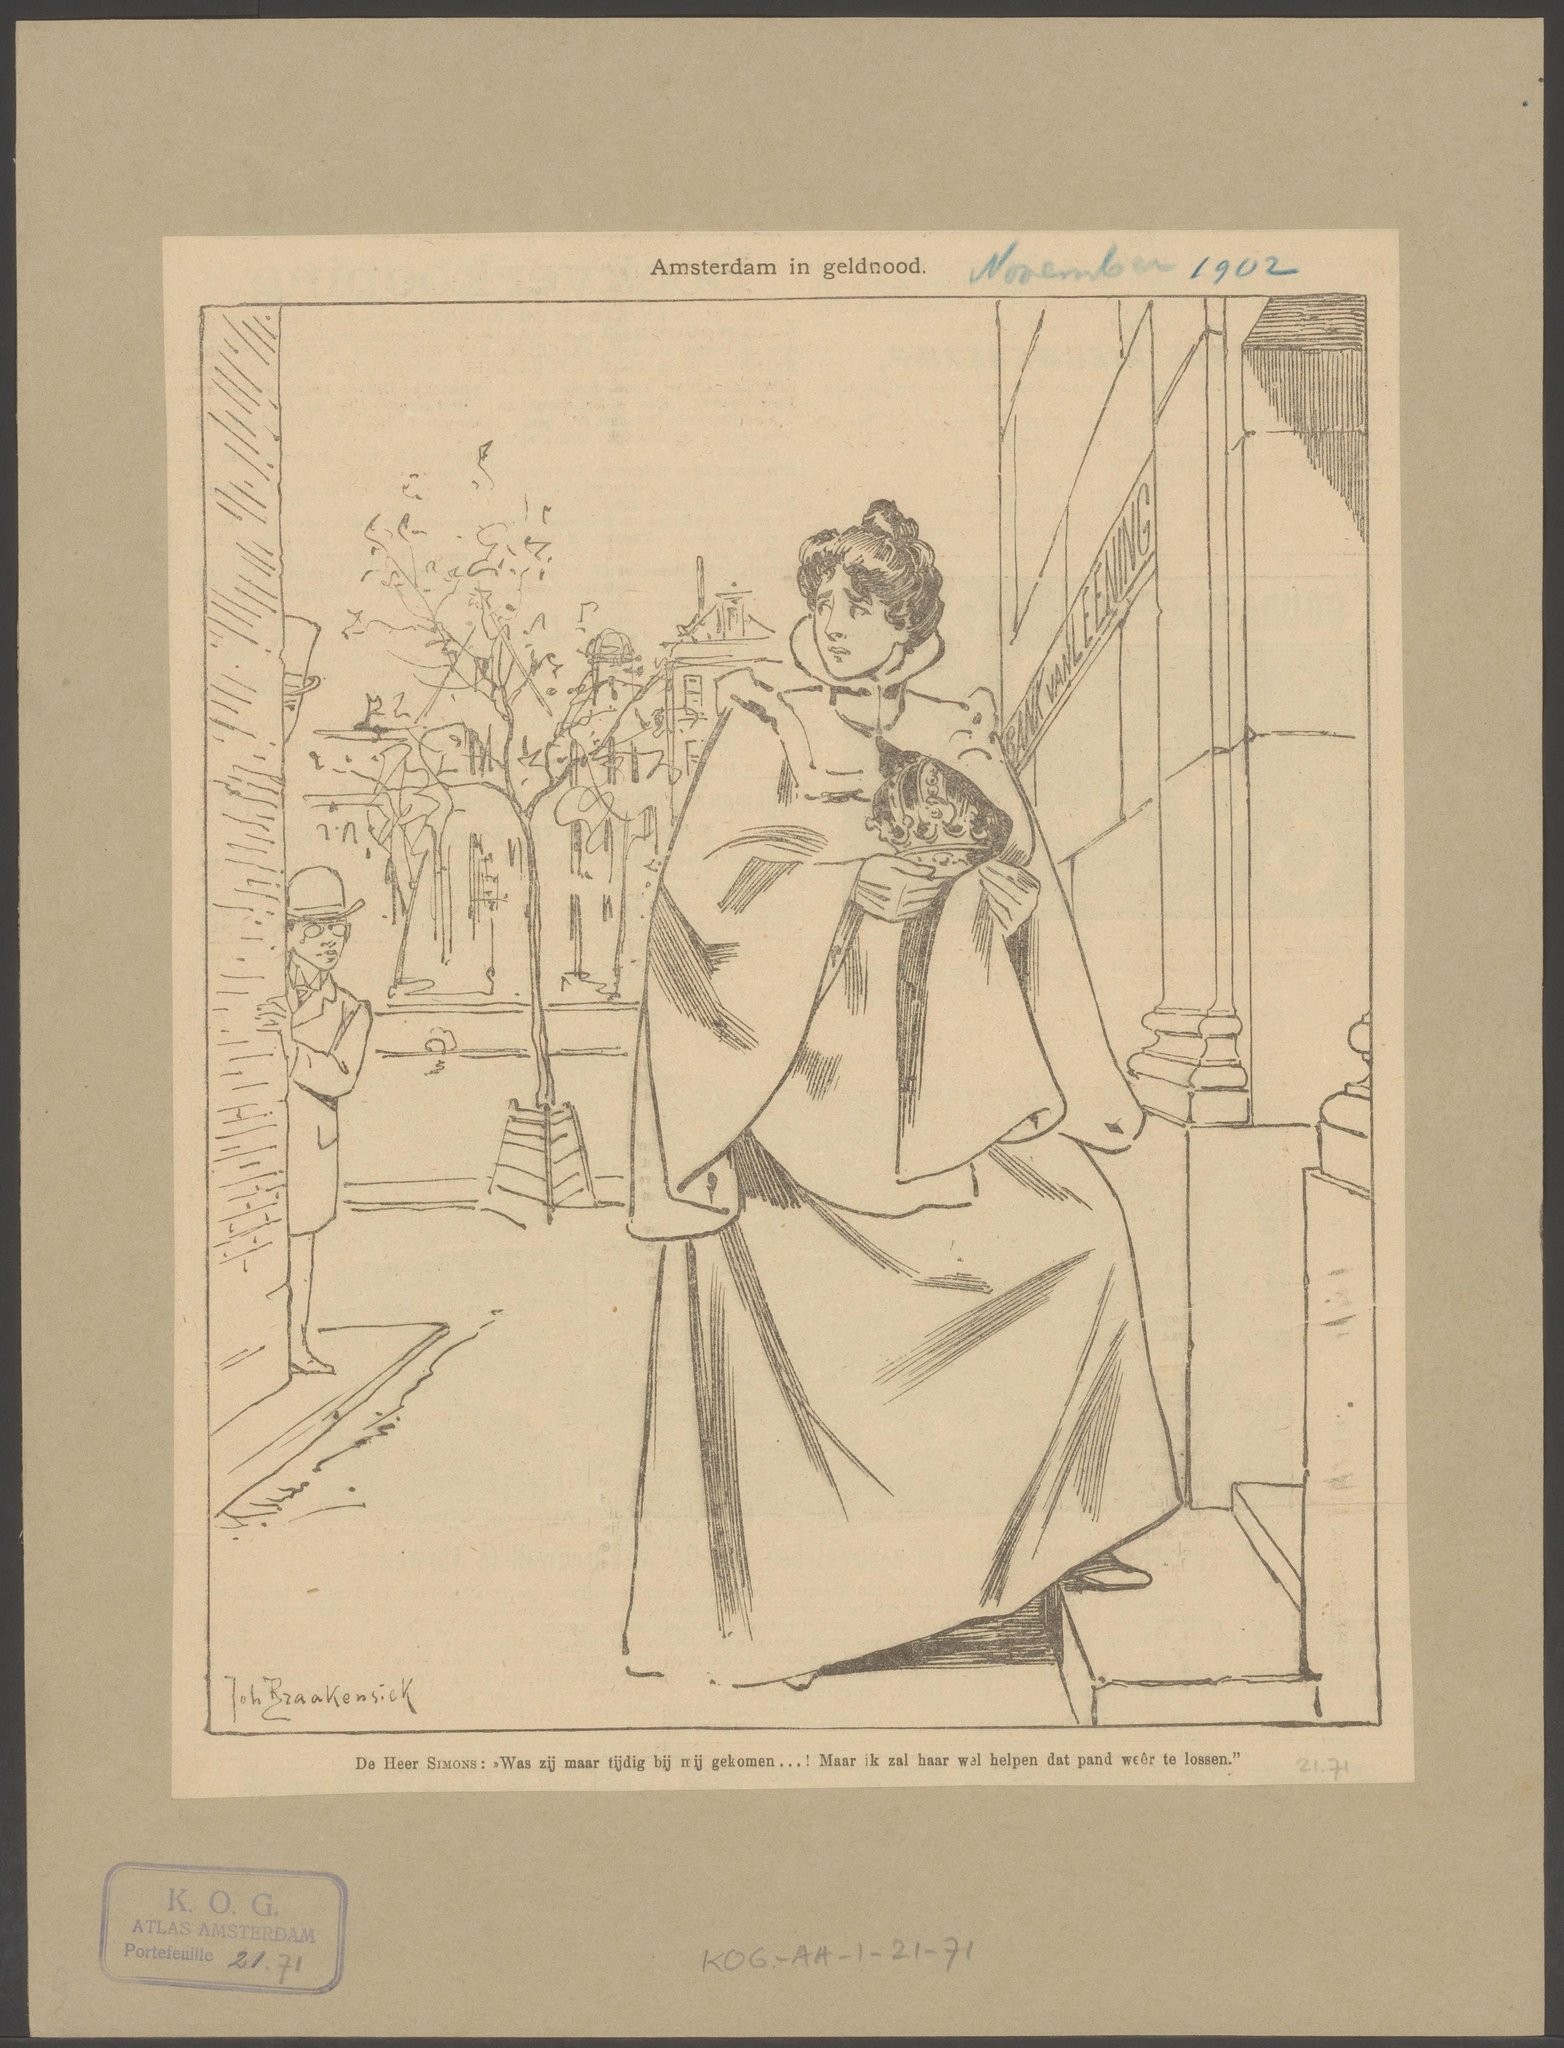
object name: photomechanical print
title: Leo Simons kijkt toe hoe Koningin Wilhelmina een pand betreedt en haar kroon verbergt onder haar mantel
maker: Anonymous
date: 1902-1911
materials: paper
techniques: letterpress printing, line block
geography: amsterdam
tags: the hague, print maker, wilhelmina of the netherlands, politician, e.g. party leader, bank, political caricatures and satires, amsterdam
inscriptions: collector's mark: Lugt 1641b, date: ‘November 1902’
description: Gepubliceerd als bijvoegsel bij 'De Amsterdammer' van 9 november 1902.